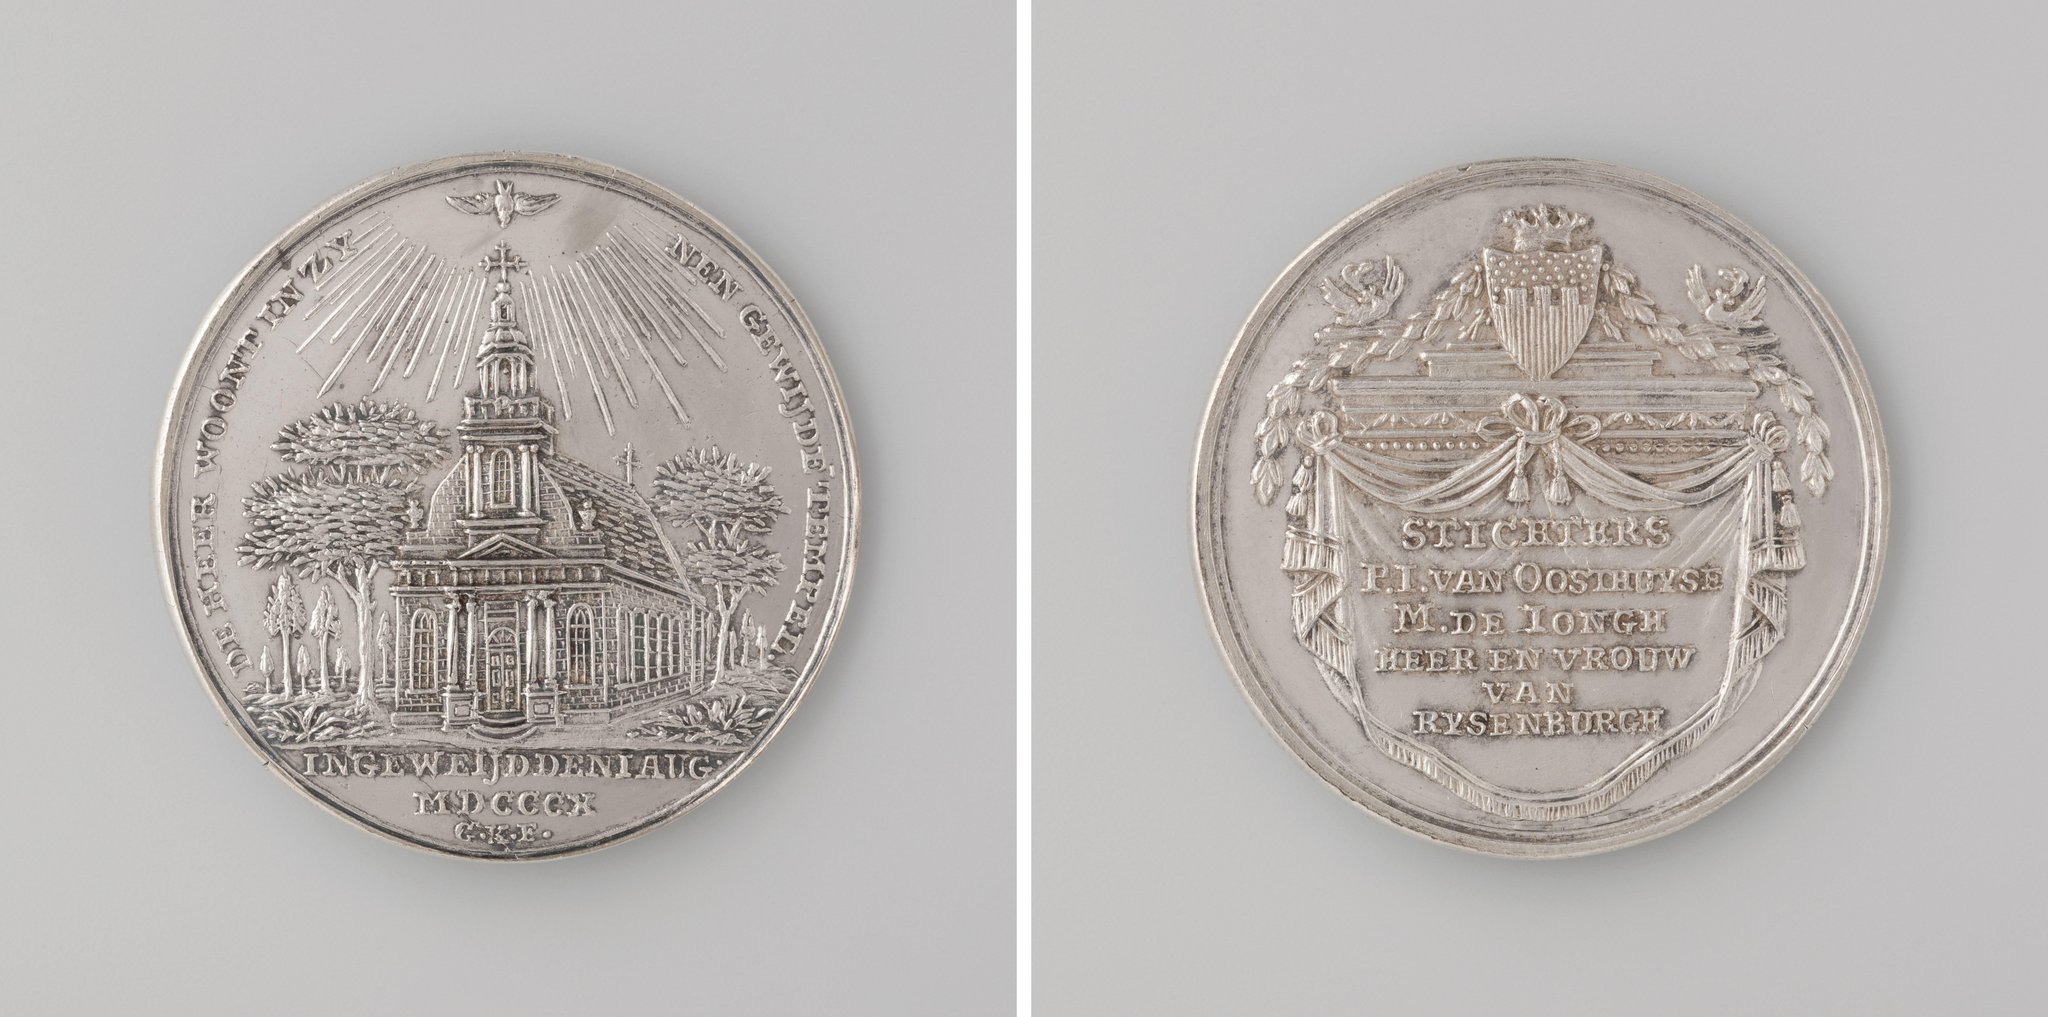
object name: history medal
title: Inwijding van de Roomskatholieke kerk te Rijsenburg, gesticht door Petrus Judocus van Oosthuysen en Margaretha de Jongh, Heer en Vrouwe van Rijsenburgh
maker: gerrit klouzing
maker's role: medailleur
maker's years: 1794-1881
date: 1810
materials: silver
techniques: striking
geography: netherlands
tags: petrus judocus van oosthuysen, rijsenburg, margaretha de jongh, sint-petrus'-bandenkerk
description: Zilveren penning. Voorzijde: Heilige Geest, voorgeteld als duif in hemellicht boven kerkgebouw binnen omschrift; afsnede: opschrift. Keerzijde: gekroond wapenschild omhangen met bladerguirlandes boven doek met opschrift